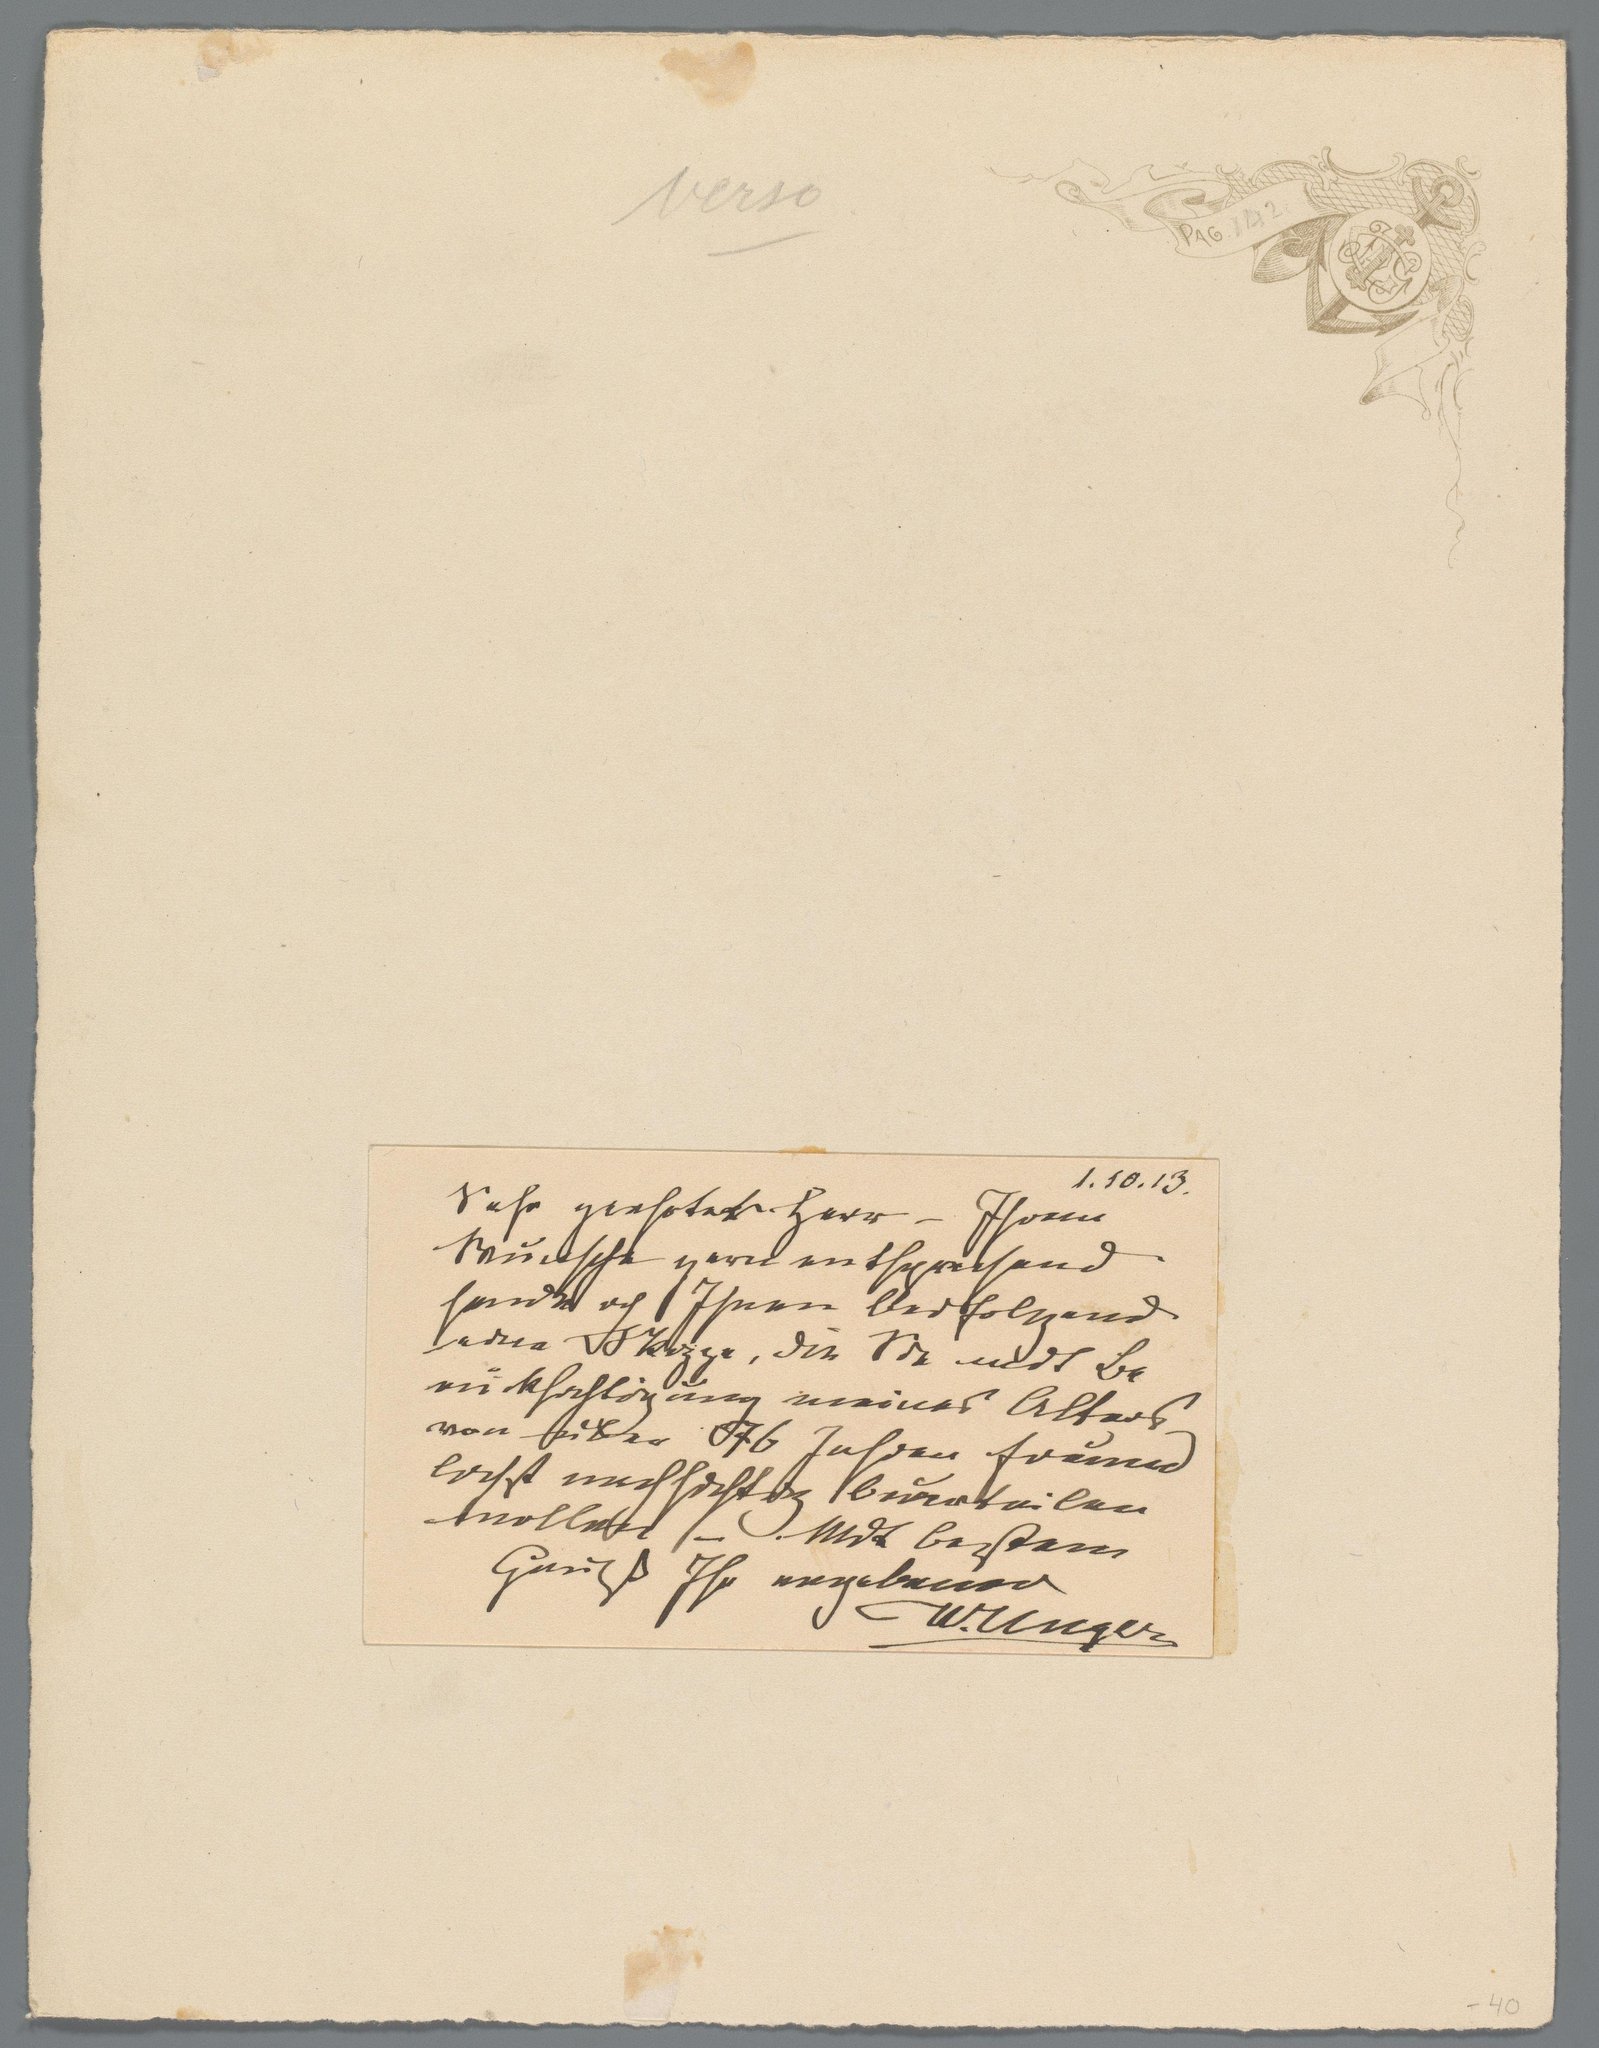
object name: drawing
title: Bericht van William Unger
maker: william unger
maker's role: draughtsman, painter, print maker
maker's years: 1837-1932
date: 1913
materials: paper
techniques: lithograph, pen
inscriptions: date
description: Tekening op een blad met gepersonaliseerde decoratie in de vorm van een anker met monogram, met ruimte voor een paginanummer.